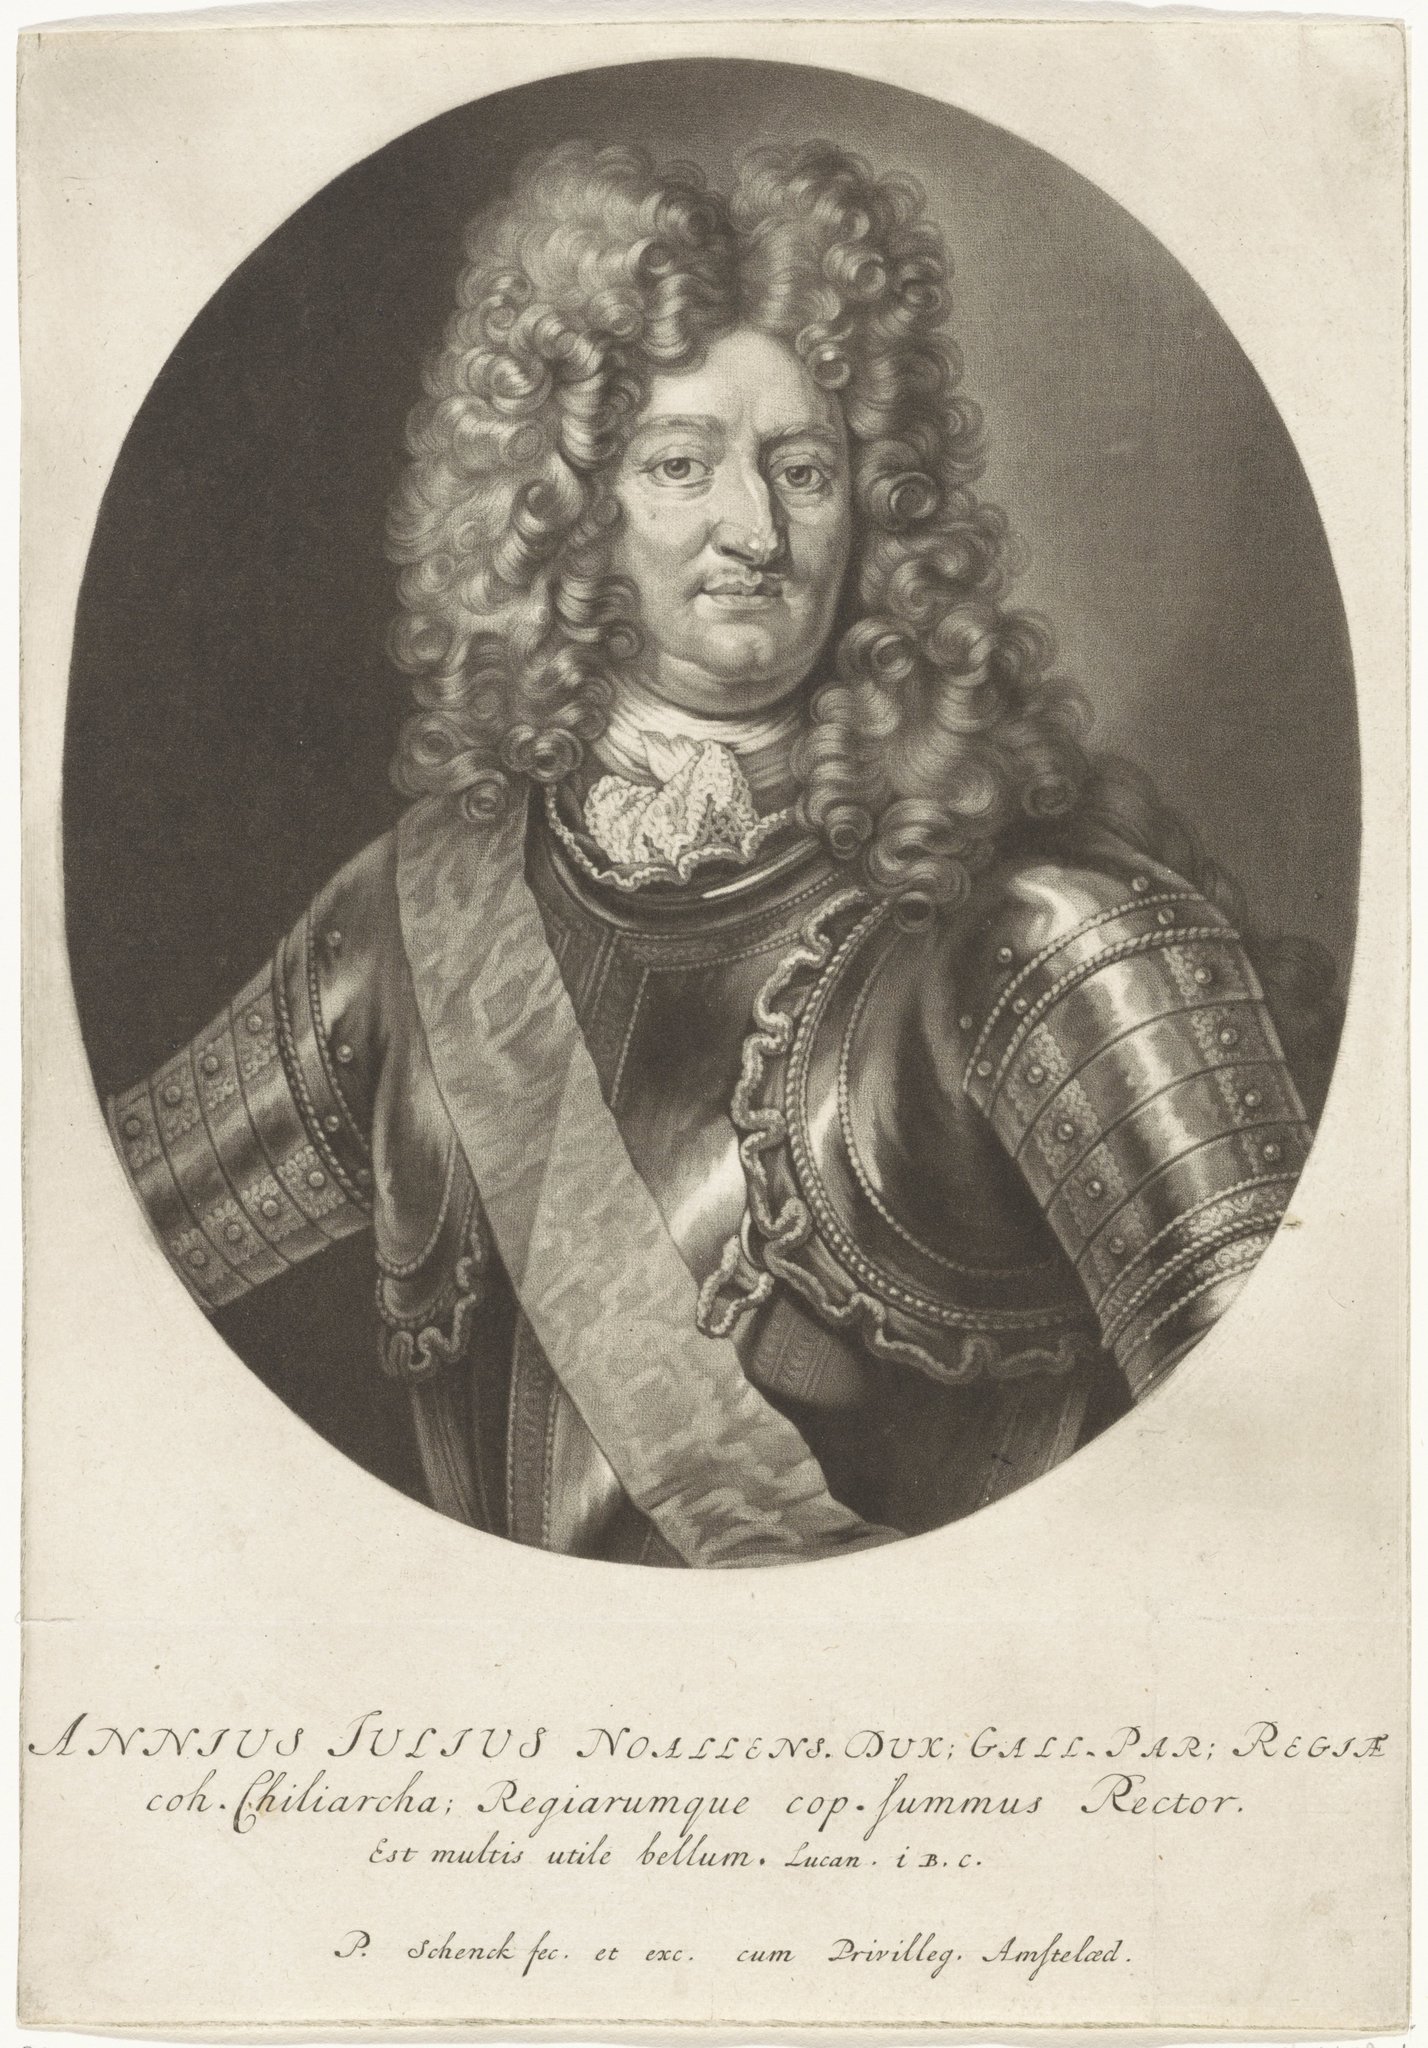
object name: print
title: Portret van Anne Jules hertog van Noailles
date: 1670-1713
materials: paper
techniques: engraving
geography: amsterdam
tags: paris, anne jules hertog van noailles, armour, wig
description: Anne Jules hertog van Noailles en maarschalk van Frankrijk, in harnas.